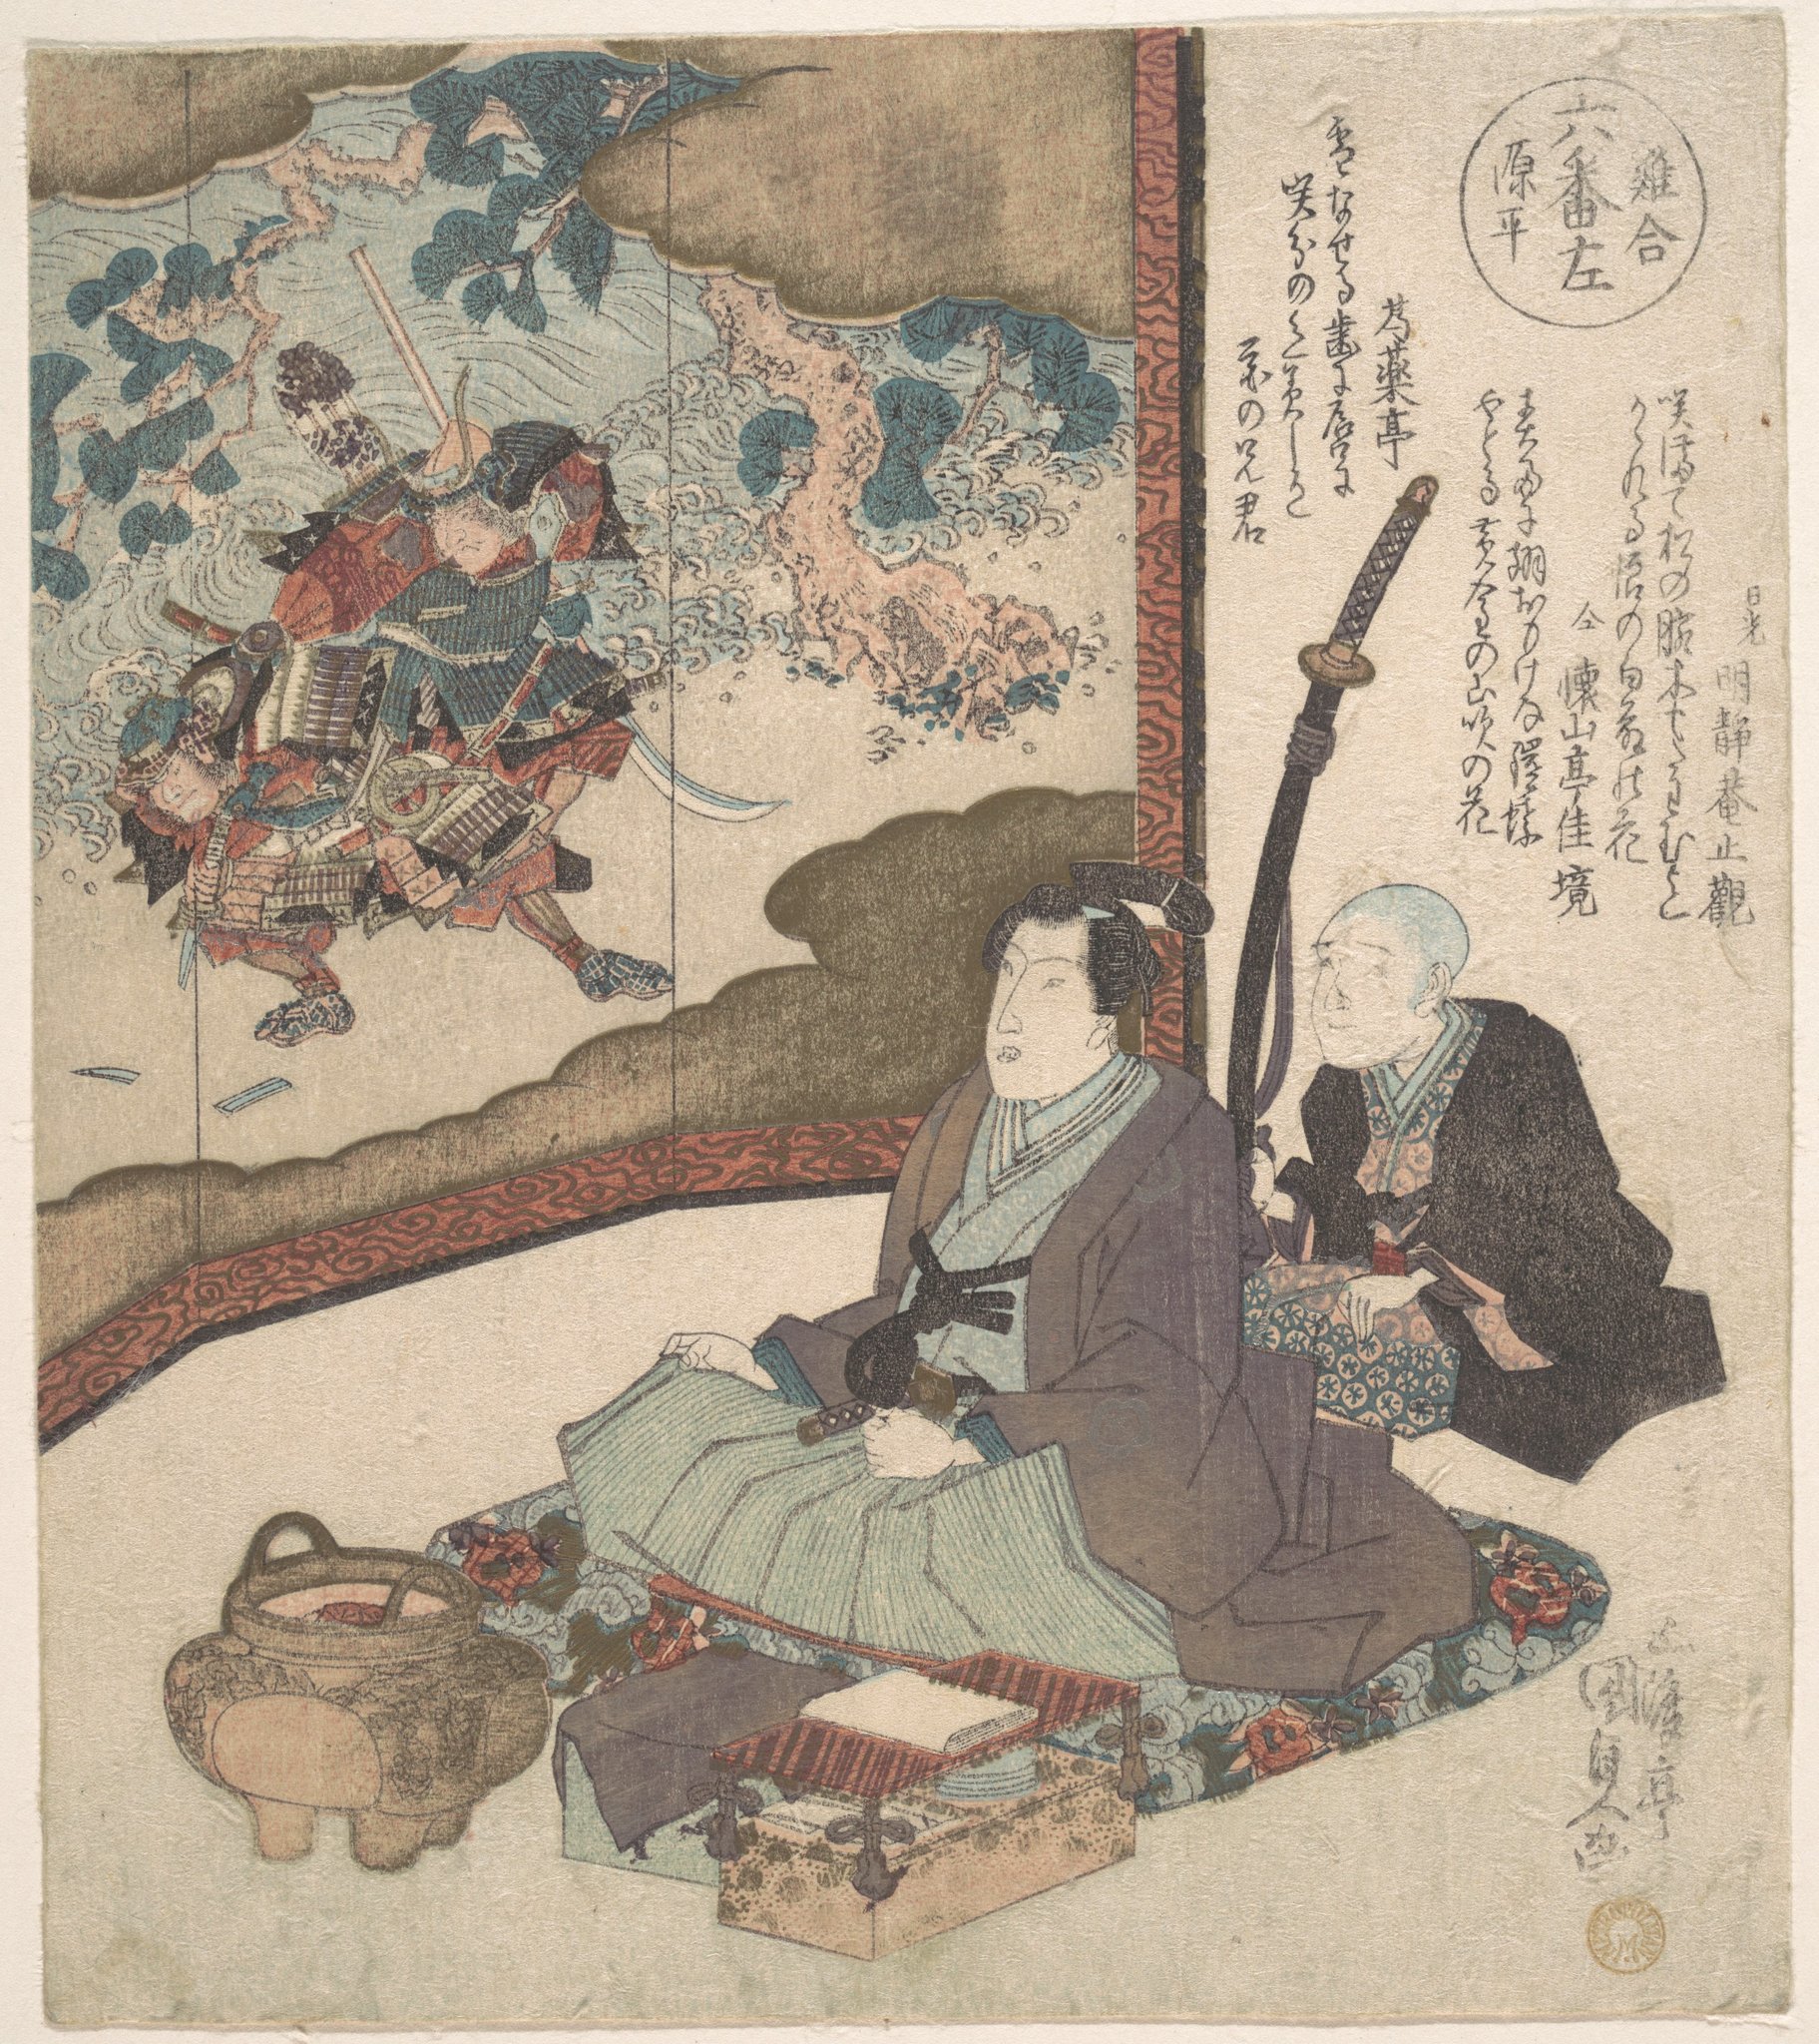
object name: print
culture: japanese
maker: utagawa kunisada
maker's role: artist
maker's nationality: japanese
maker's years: 1786-1864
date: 1840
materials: ink, paper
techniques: surimono, woodblock print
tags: swords,men,screens